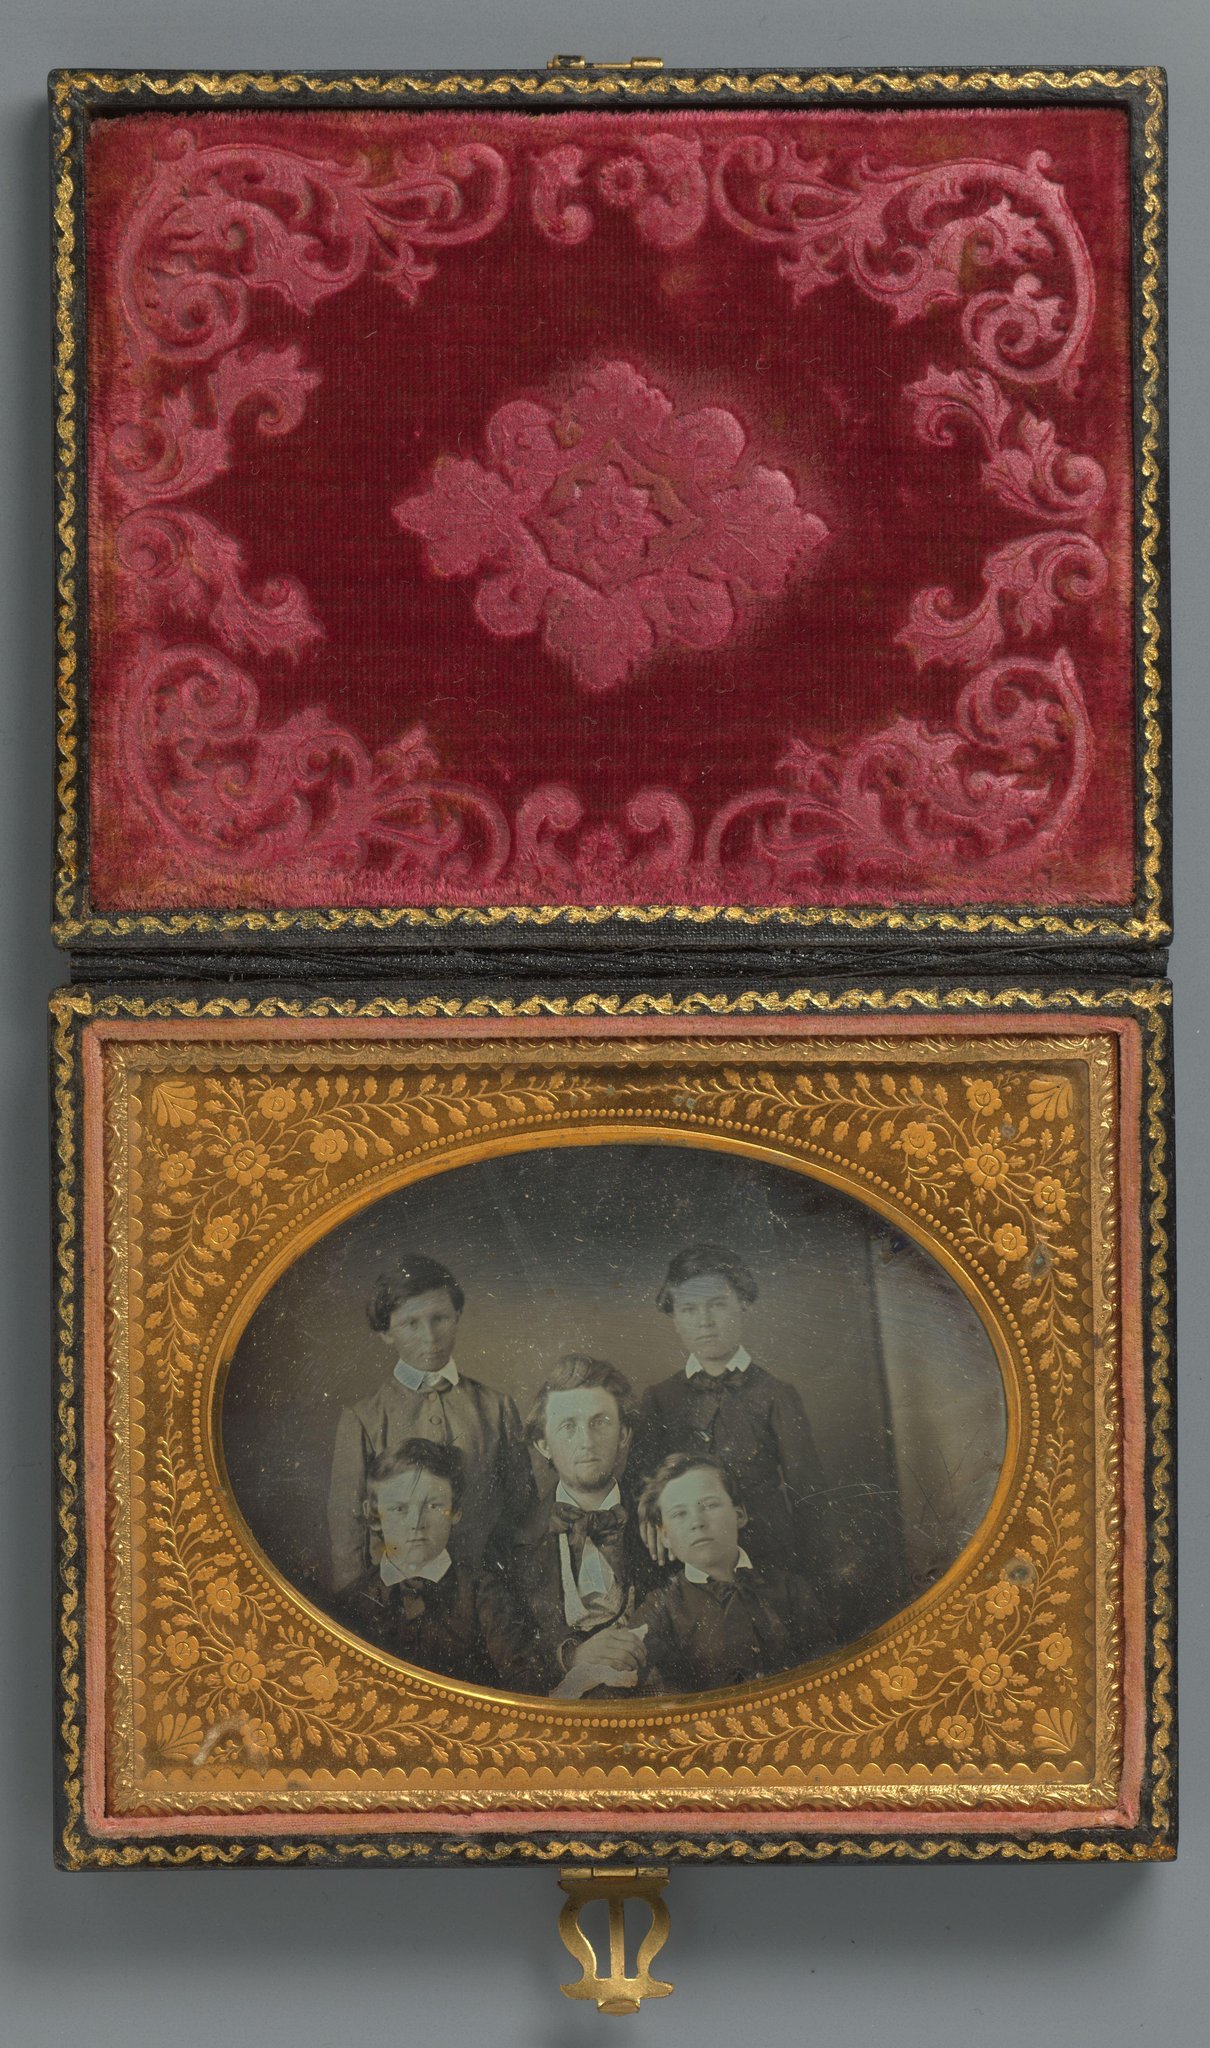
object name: photograph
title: Portret van een onbekende vader en vier zoons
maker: Anonymous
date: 1840-1860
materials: copper, glass, leather, velvet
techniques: daguerreotype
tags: adult man, historical persons, father and son(s) (family group), child (at home)